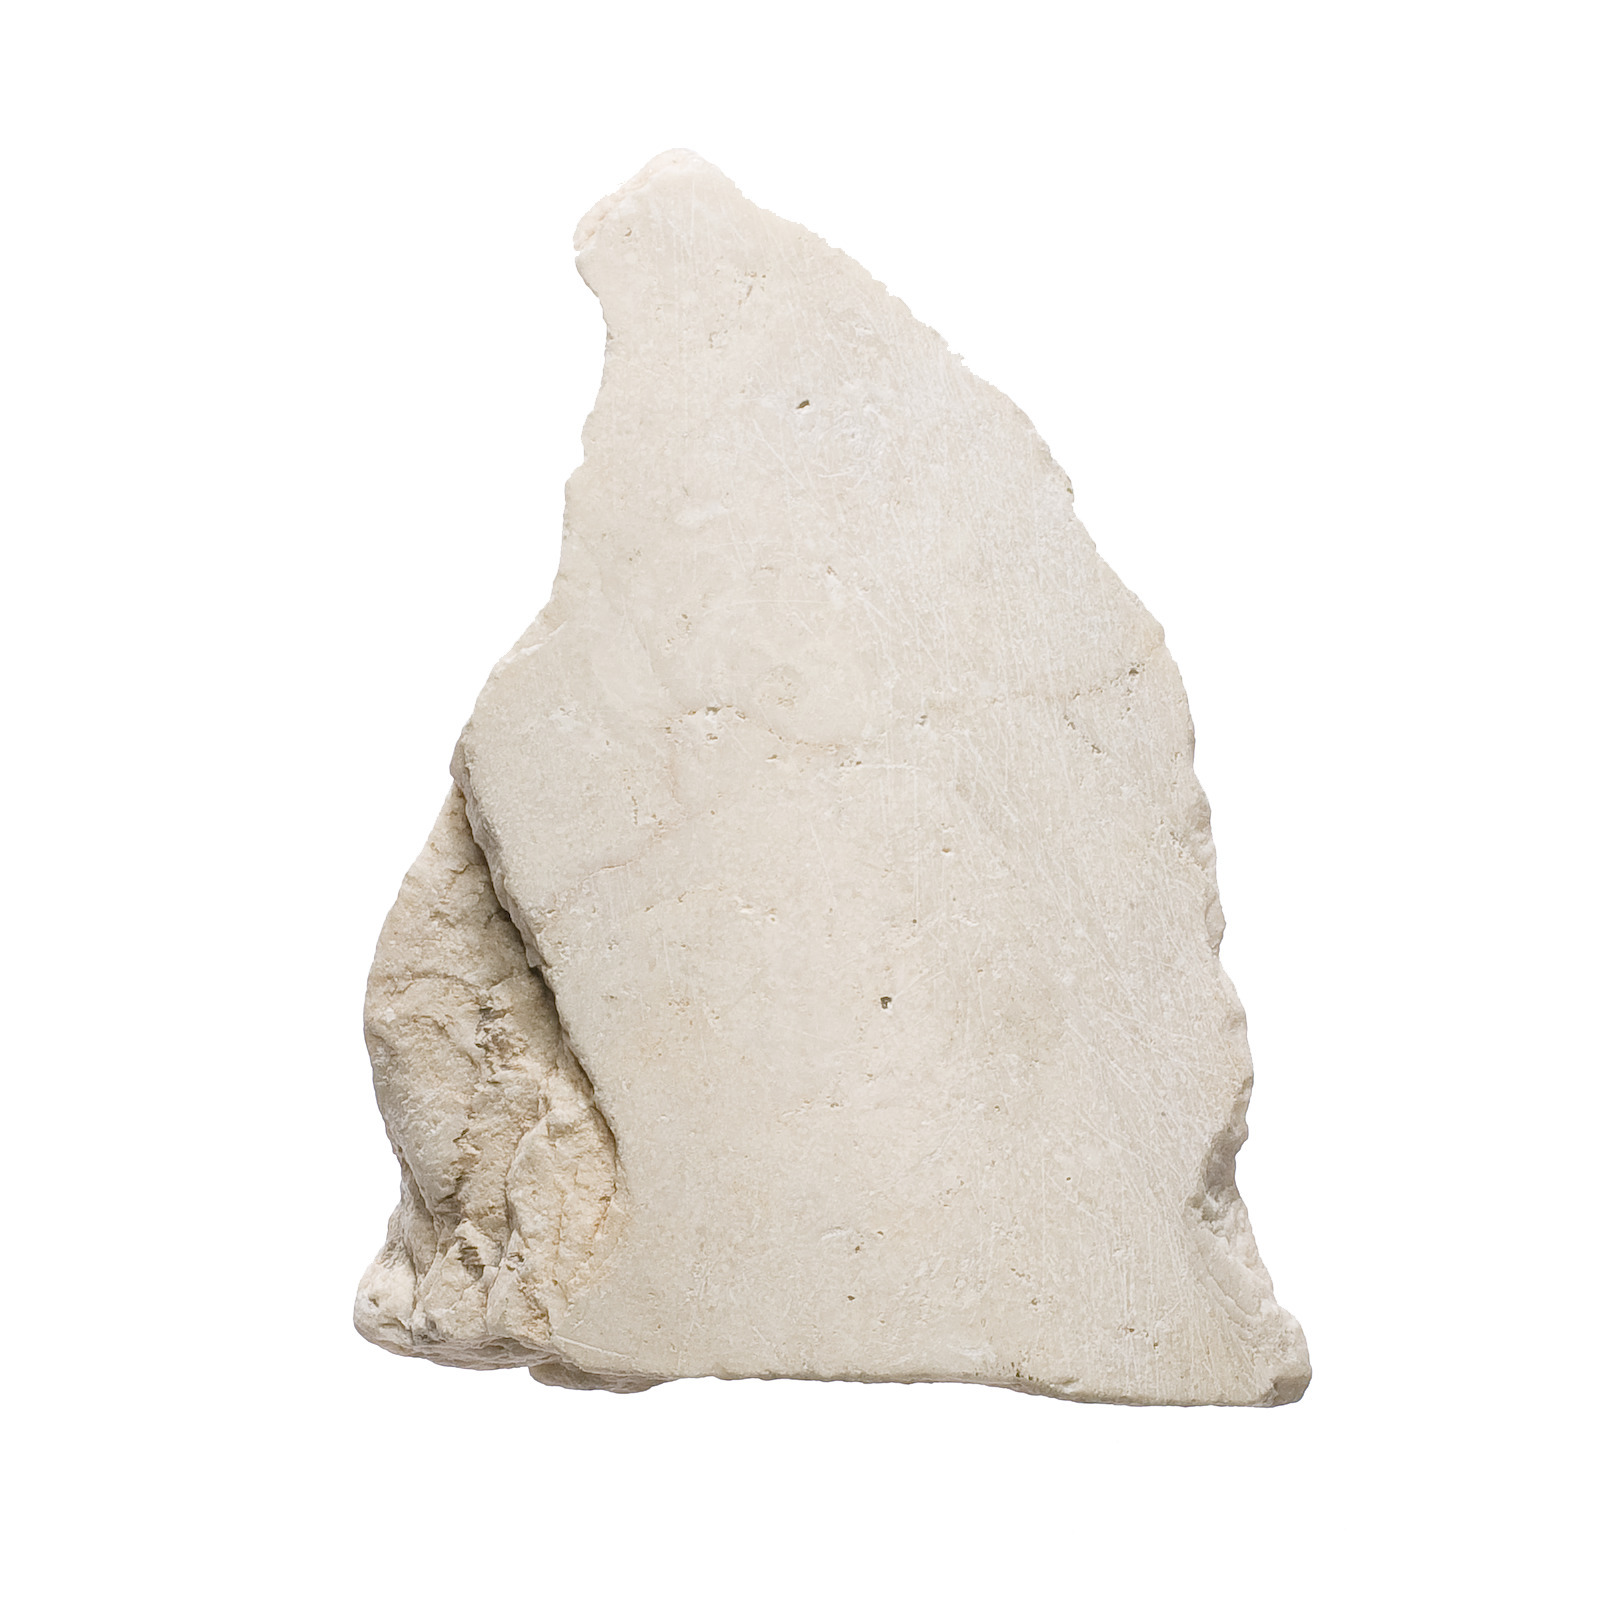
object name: limb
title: Limb (?)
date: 1353-1336 BCE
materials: limestone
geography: egypt